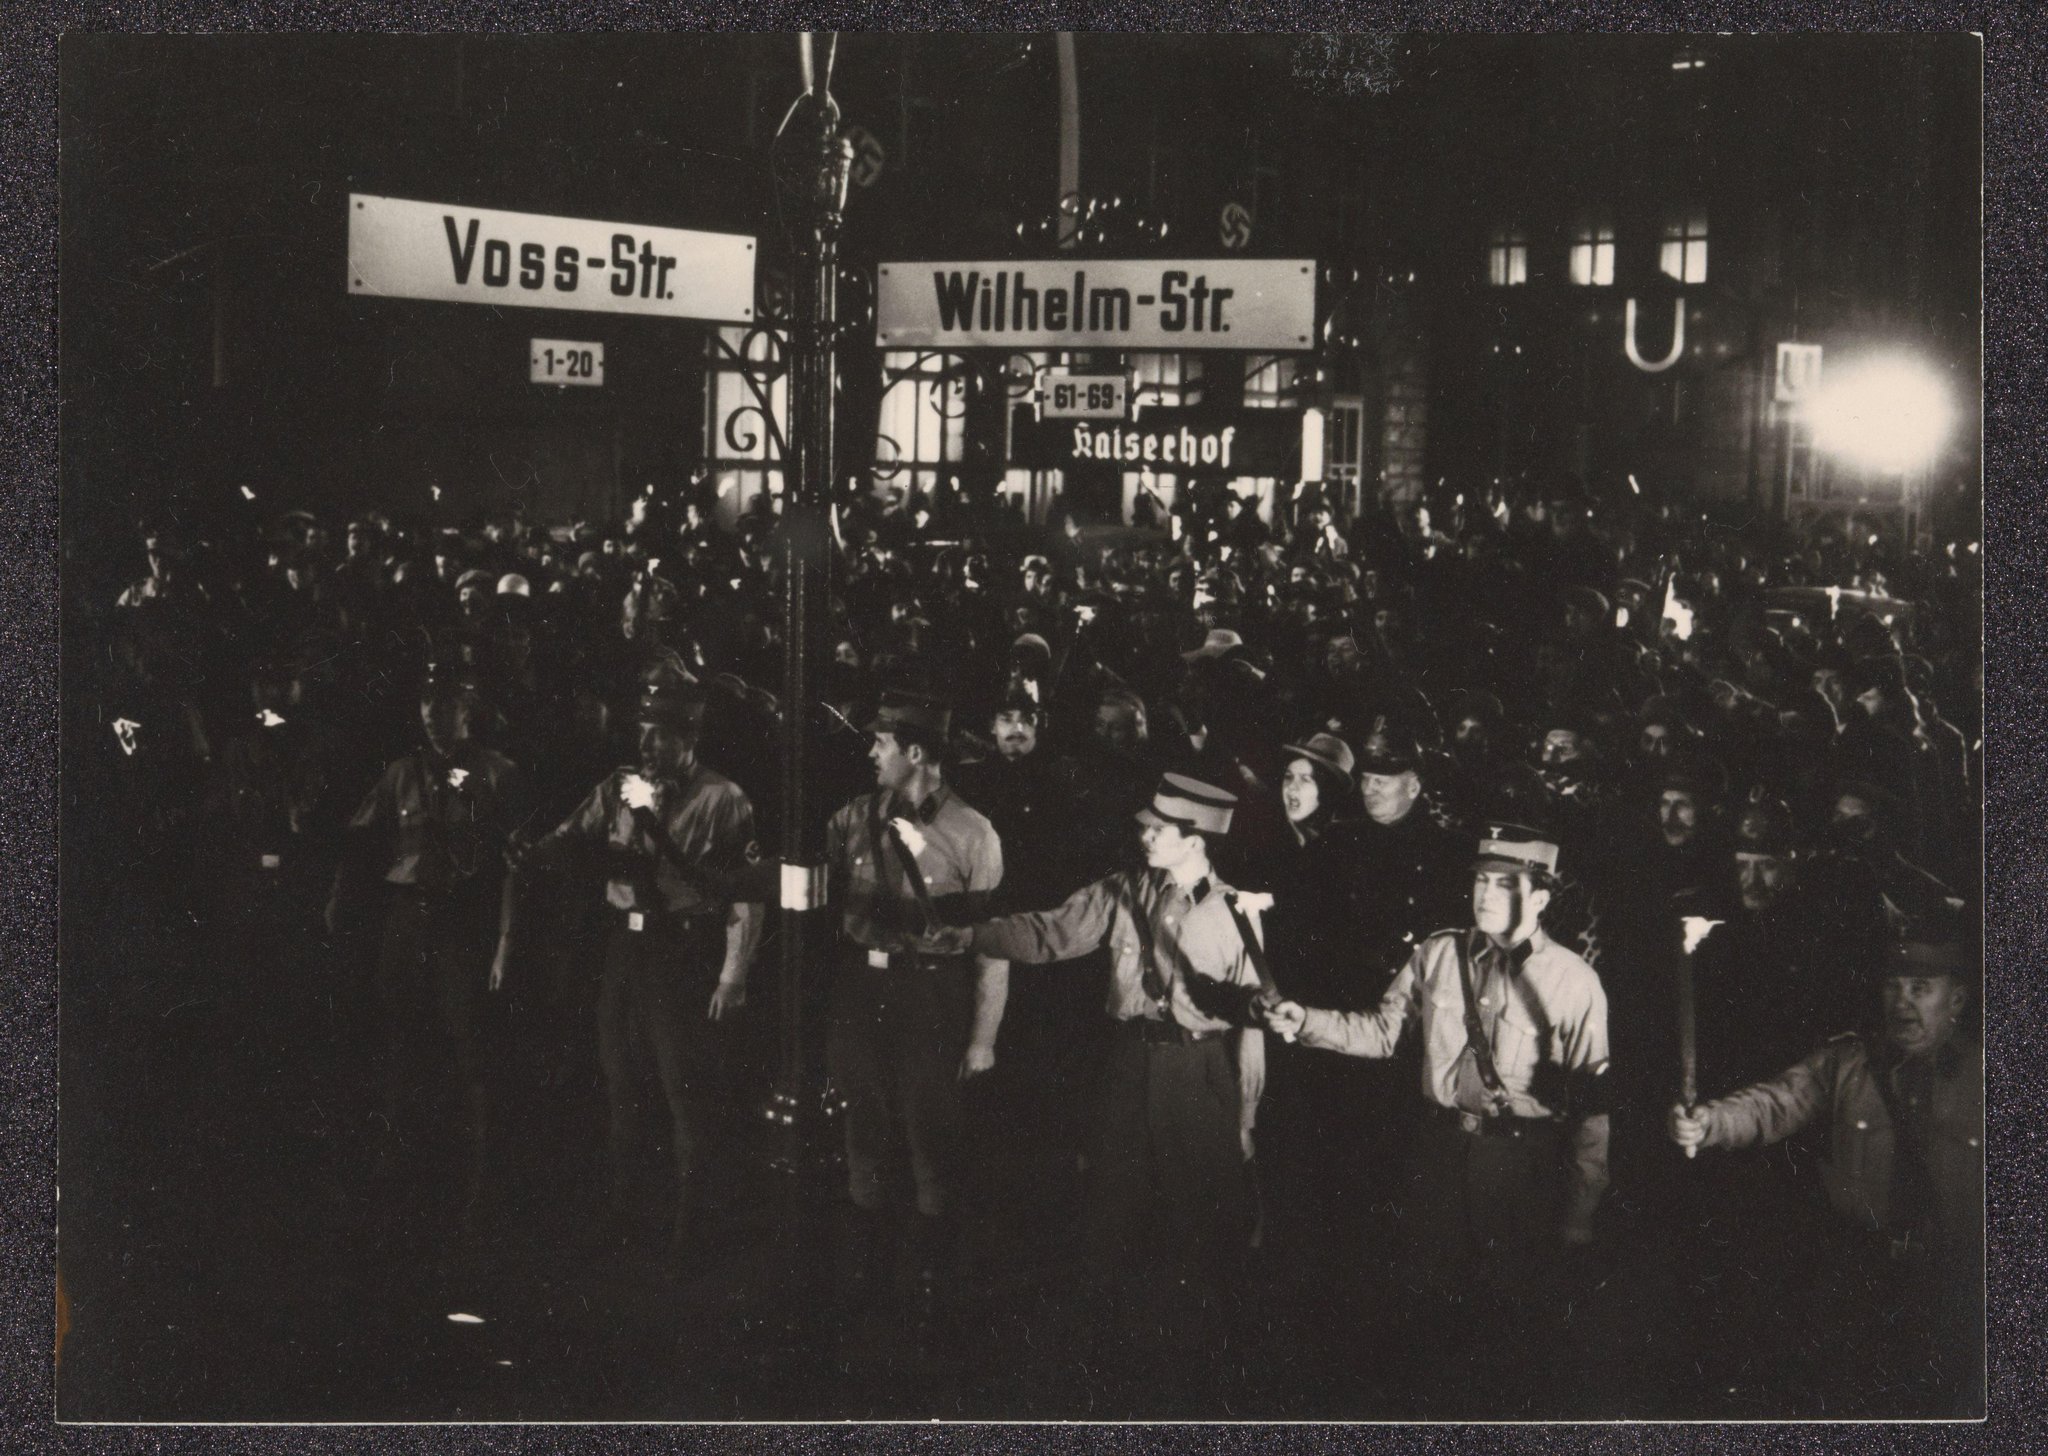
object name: photograph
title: KLK an PTX - Die Rote Kapelle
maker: Anonymous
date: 1971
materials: paper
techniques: gelatin silver print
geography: berlin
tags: torch, political meeting, propaganda meeting, berlin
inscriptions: inscription: ‘KLK an PTX - Die Rote Kapelle/ O-Duitsl. 1971/ Horst Brandt’, stamp: ‘Nederlands Filmmuseum/ Amsterdam’